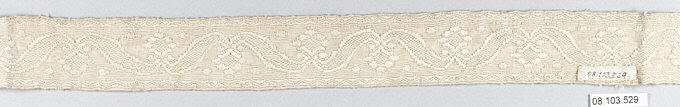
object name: galloon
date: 1701-1900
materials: silk